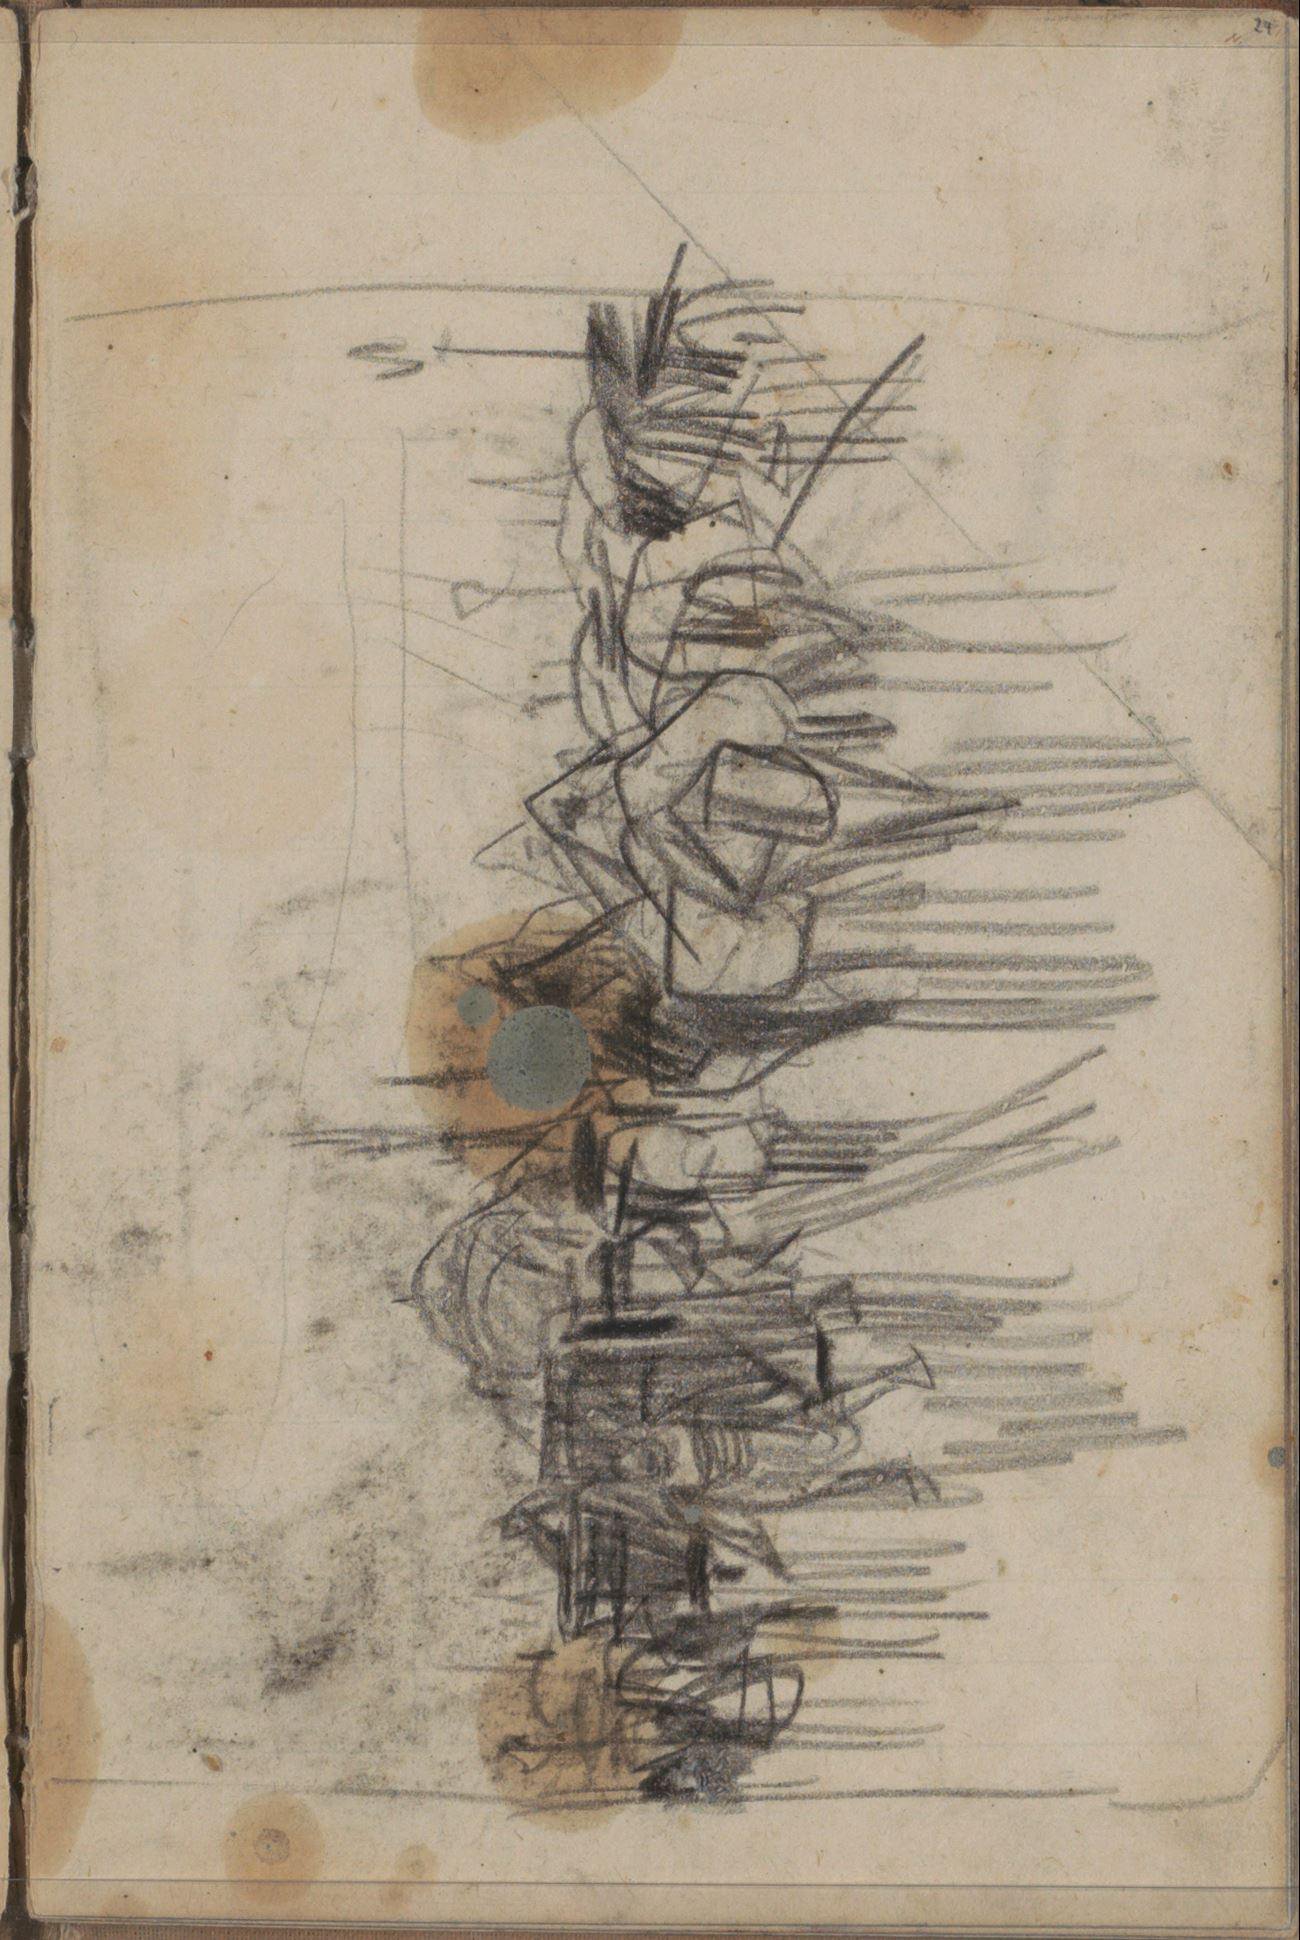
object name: sketchbook leaf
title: Figuren met een koets en dieren op een weg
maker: marius bauer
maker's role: draughtsman, print maker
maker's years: 1867-1932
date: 1888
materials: chalk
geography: istanbul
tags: four-wheeled, animal-drawn vehicle, e.g.: cab, carriage, coach, street (+ city(-scape) with figures, staffage)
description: Op de achtergrond is een moskee te zien. Pagina 24 uit een schetsboek met 58 bladen.